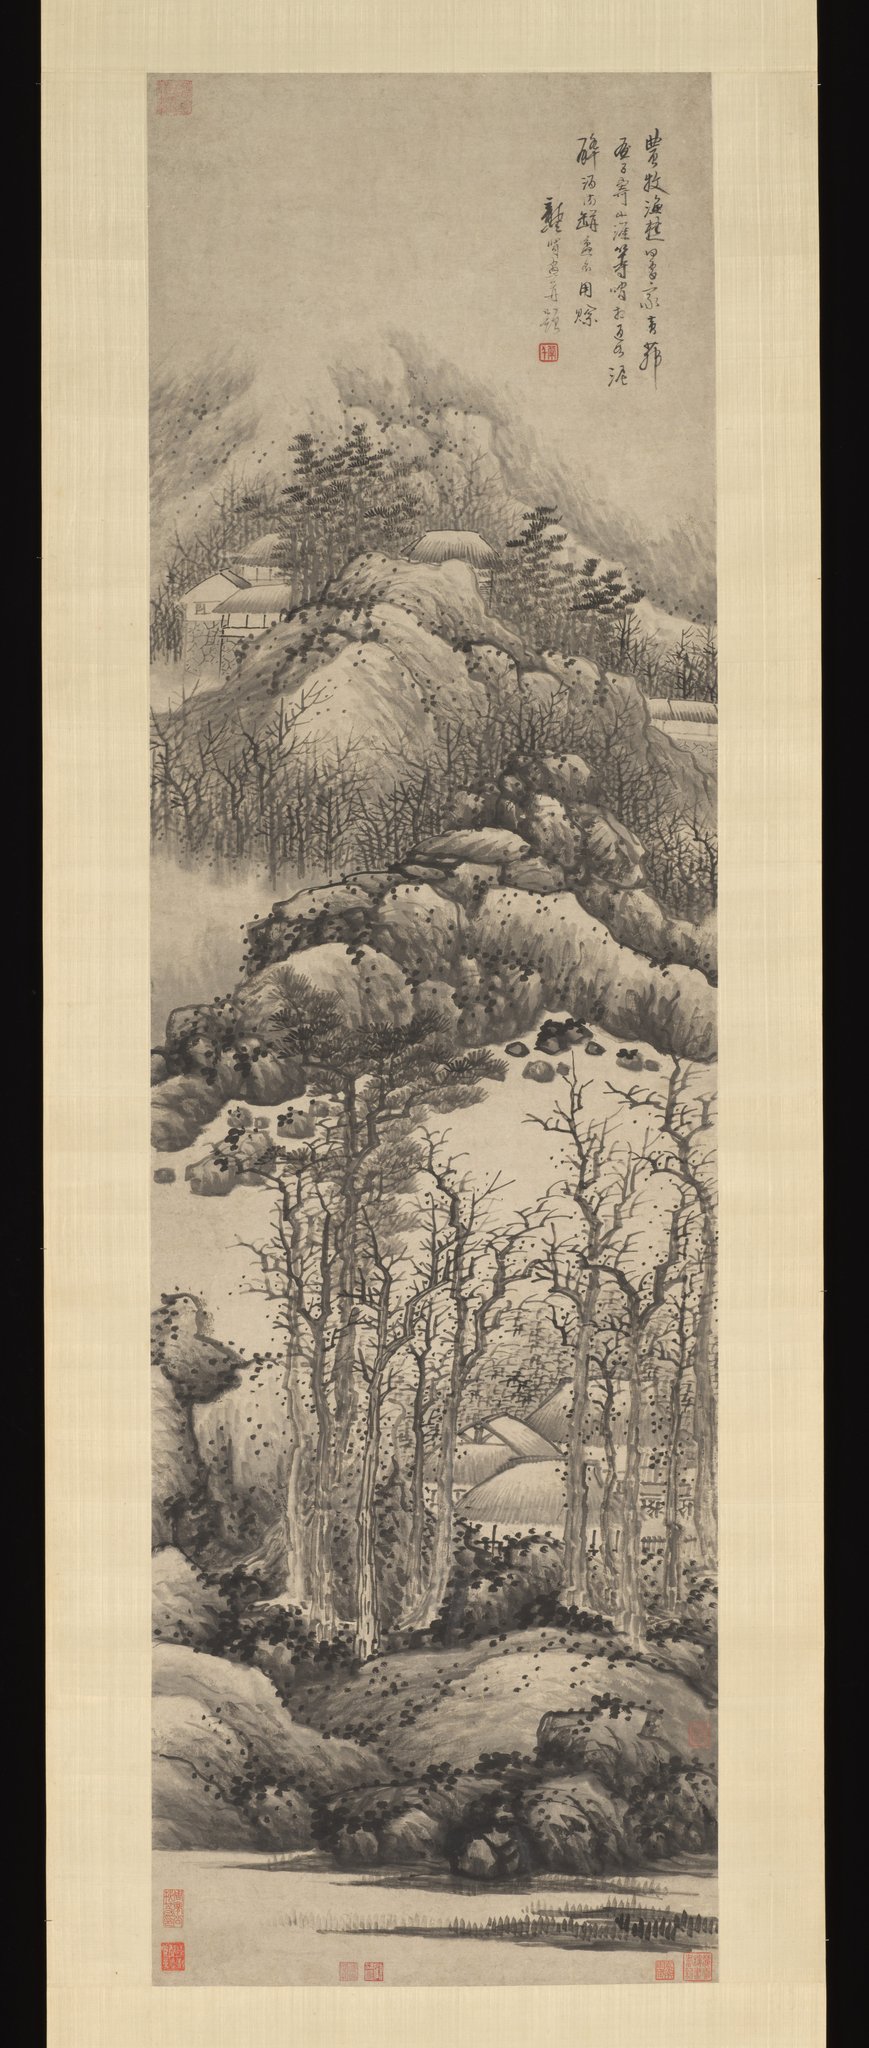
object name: hanging scroll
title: Wintry mountains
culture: chinese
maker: gong xian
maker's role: artist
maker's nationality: chinese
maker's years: 1619-1689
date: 1679-1689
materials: ink, paper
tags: mountains,landscapes,winter